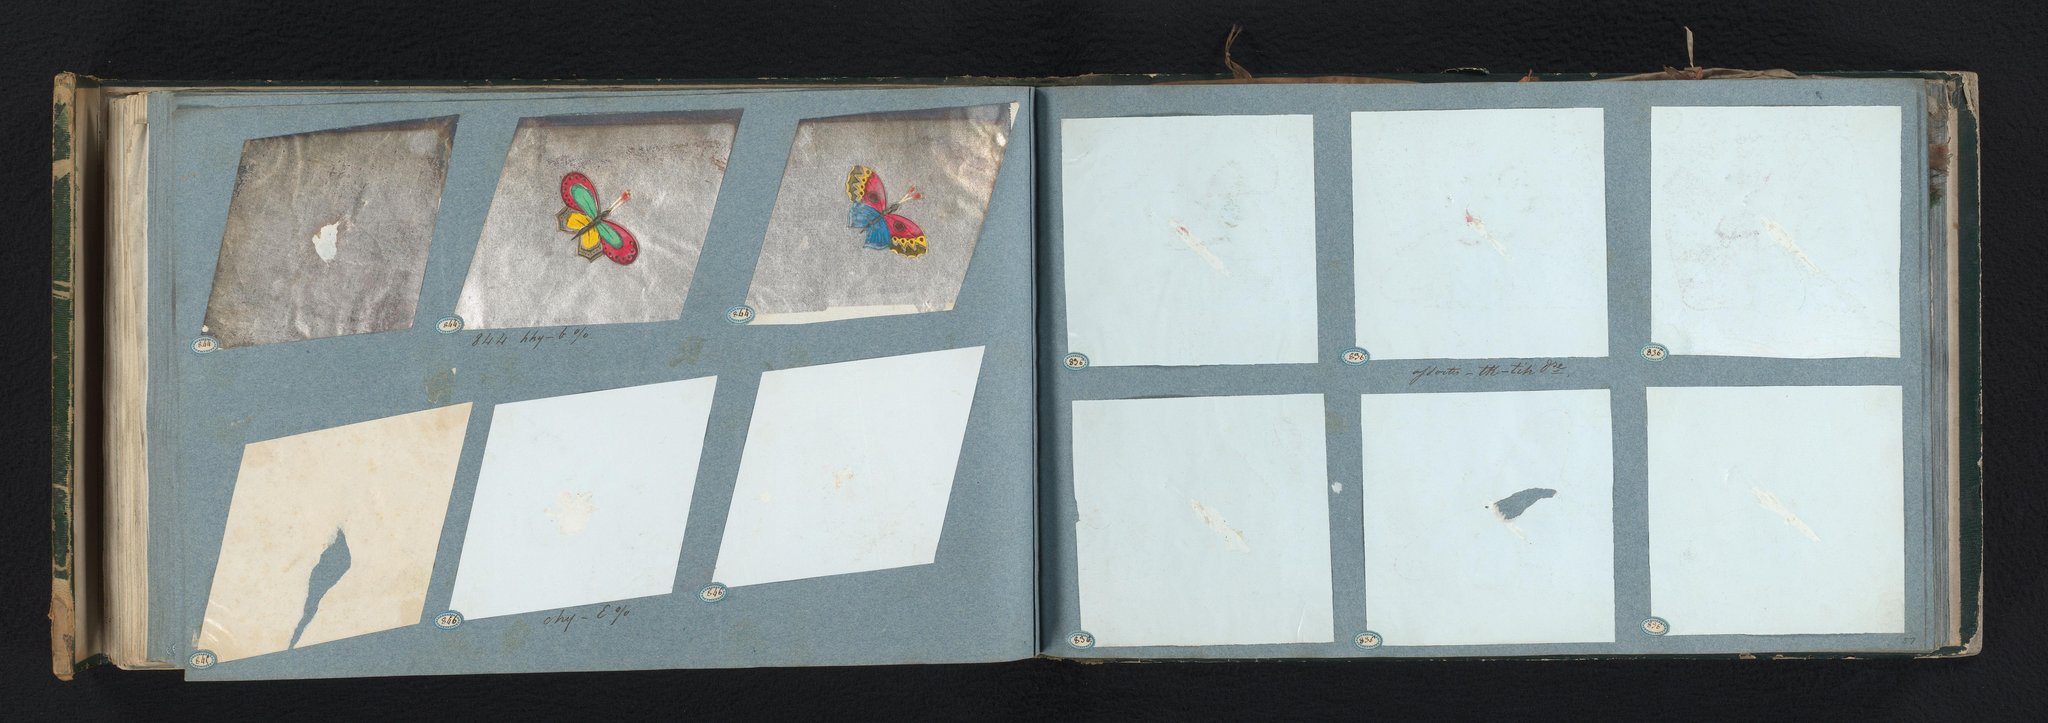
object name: album leaf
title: Twee bladzijden met stalen van zilverkleurig metaalpapier met vlinders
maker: Anonymous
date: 1830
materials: ink, paper, silver leaf, watercolor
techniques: etching, hand coloring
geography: france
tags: ornaments ~ art, insects: butterfly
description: Twee bladzijden met 2 stalen van papieren met vignetten. Links de enige twee nog intacte gedrukte en ingekleurde vignetten van vlinders opgeplakt op zilverkleurig metaalpapier. Bij de overige zeven stalen zijn de vignetten, waarschijnlijk ook allemaal vlinders, weggehaald. Alle stalen voorzien van etiketten met nummers (844-896) en handgeschreven codes. Onderdeel van het stalenboek geschonken door de dames Van Rijn, vermoedelijk van een Franse papierfabrikant van luxe papieren, of diens vertegenwoordiger in Nederland, ca. 1830.